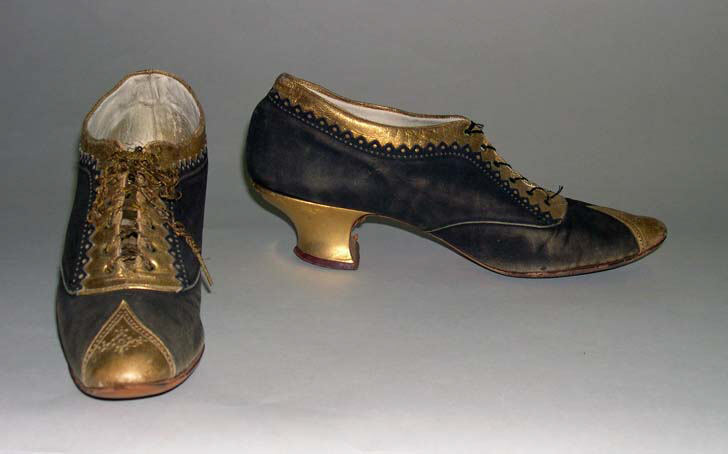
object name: shoe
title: Shoes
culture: american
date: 1875-1880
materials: leather